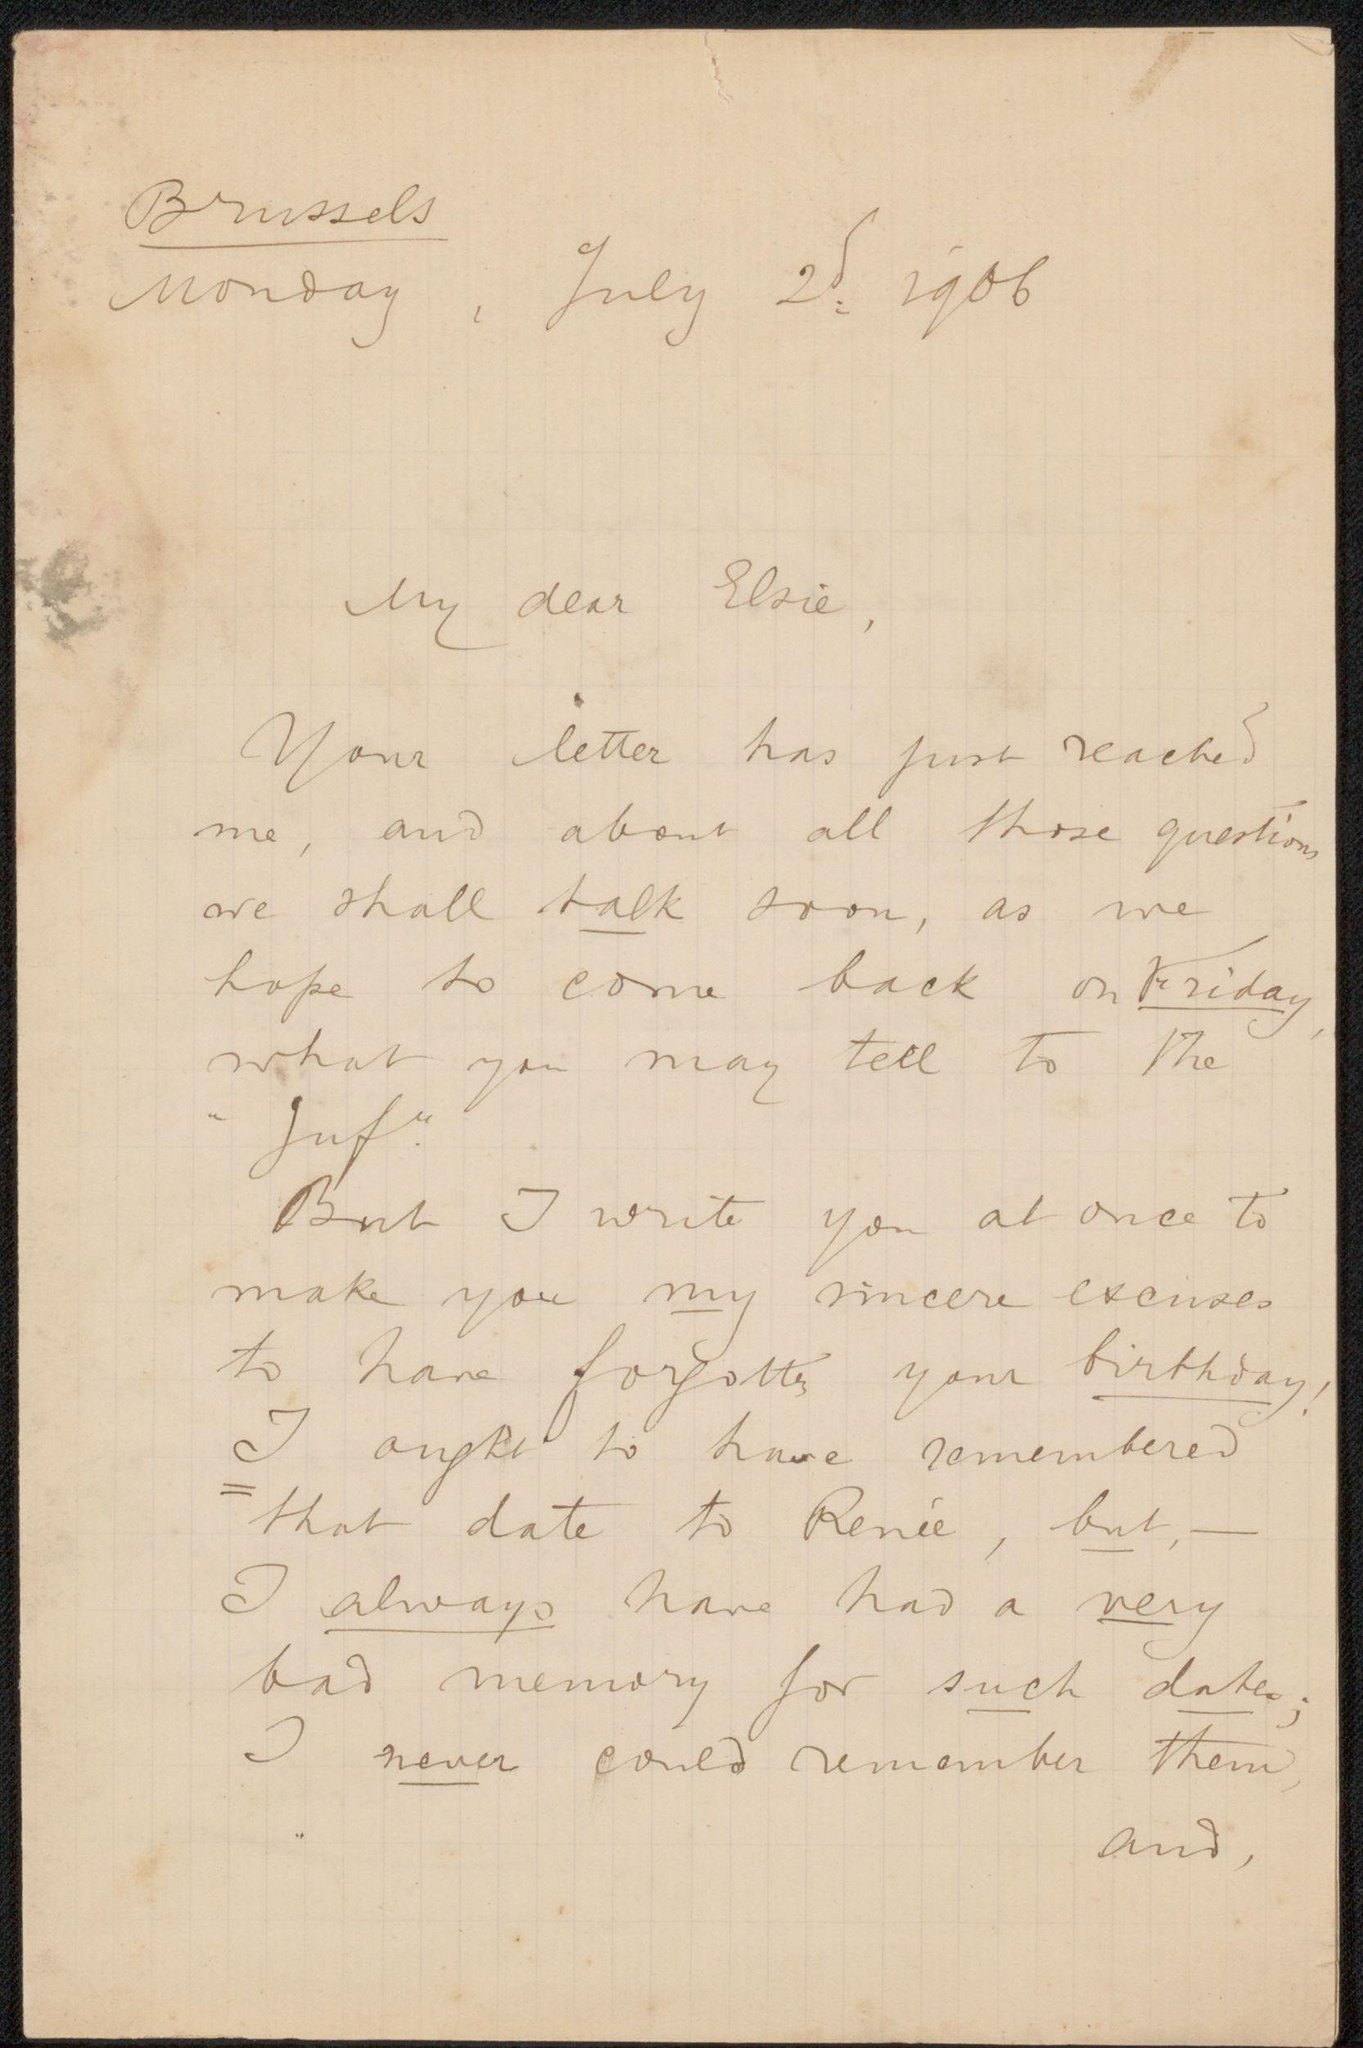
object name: letter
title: Brief aan Elsie Maud Cownie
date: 1906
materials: ink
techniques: pen, writing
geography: brussels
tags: manchester, elsie maud cownie, travelling; tourism